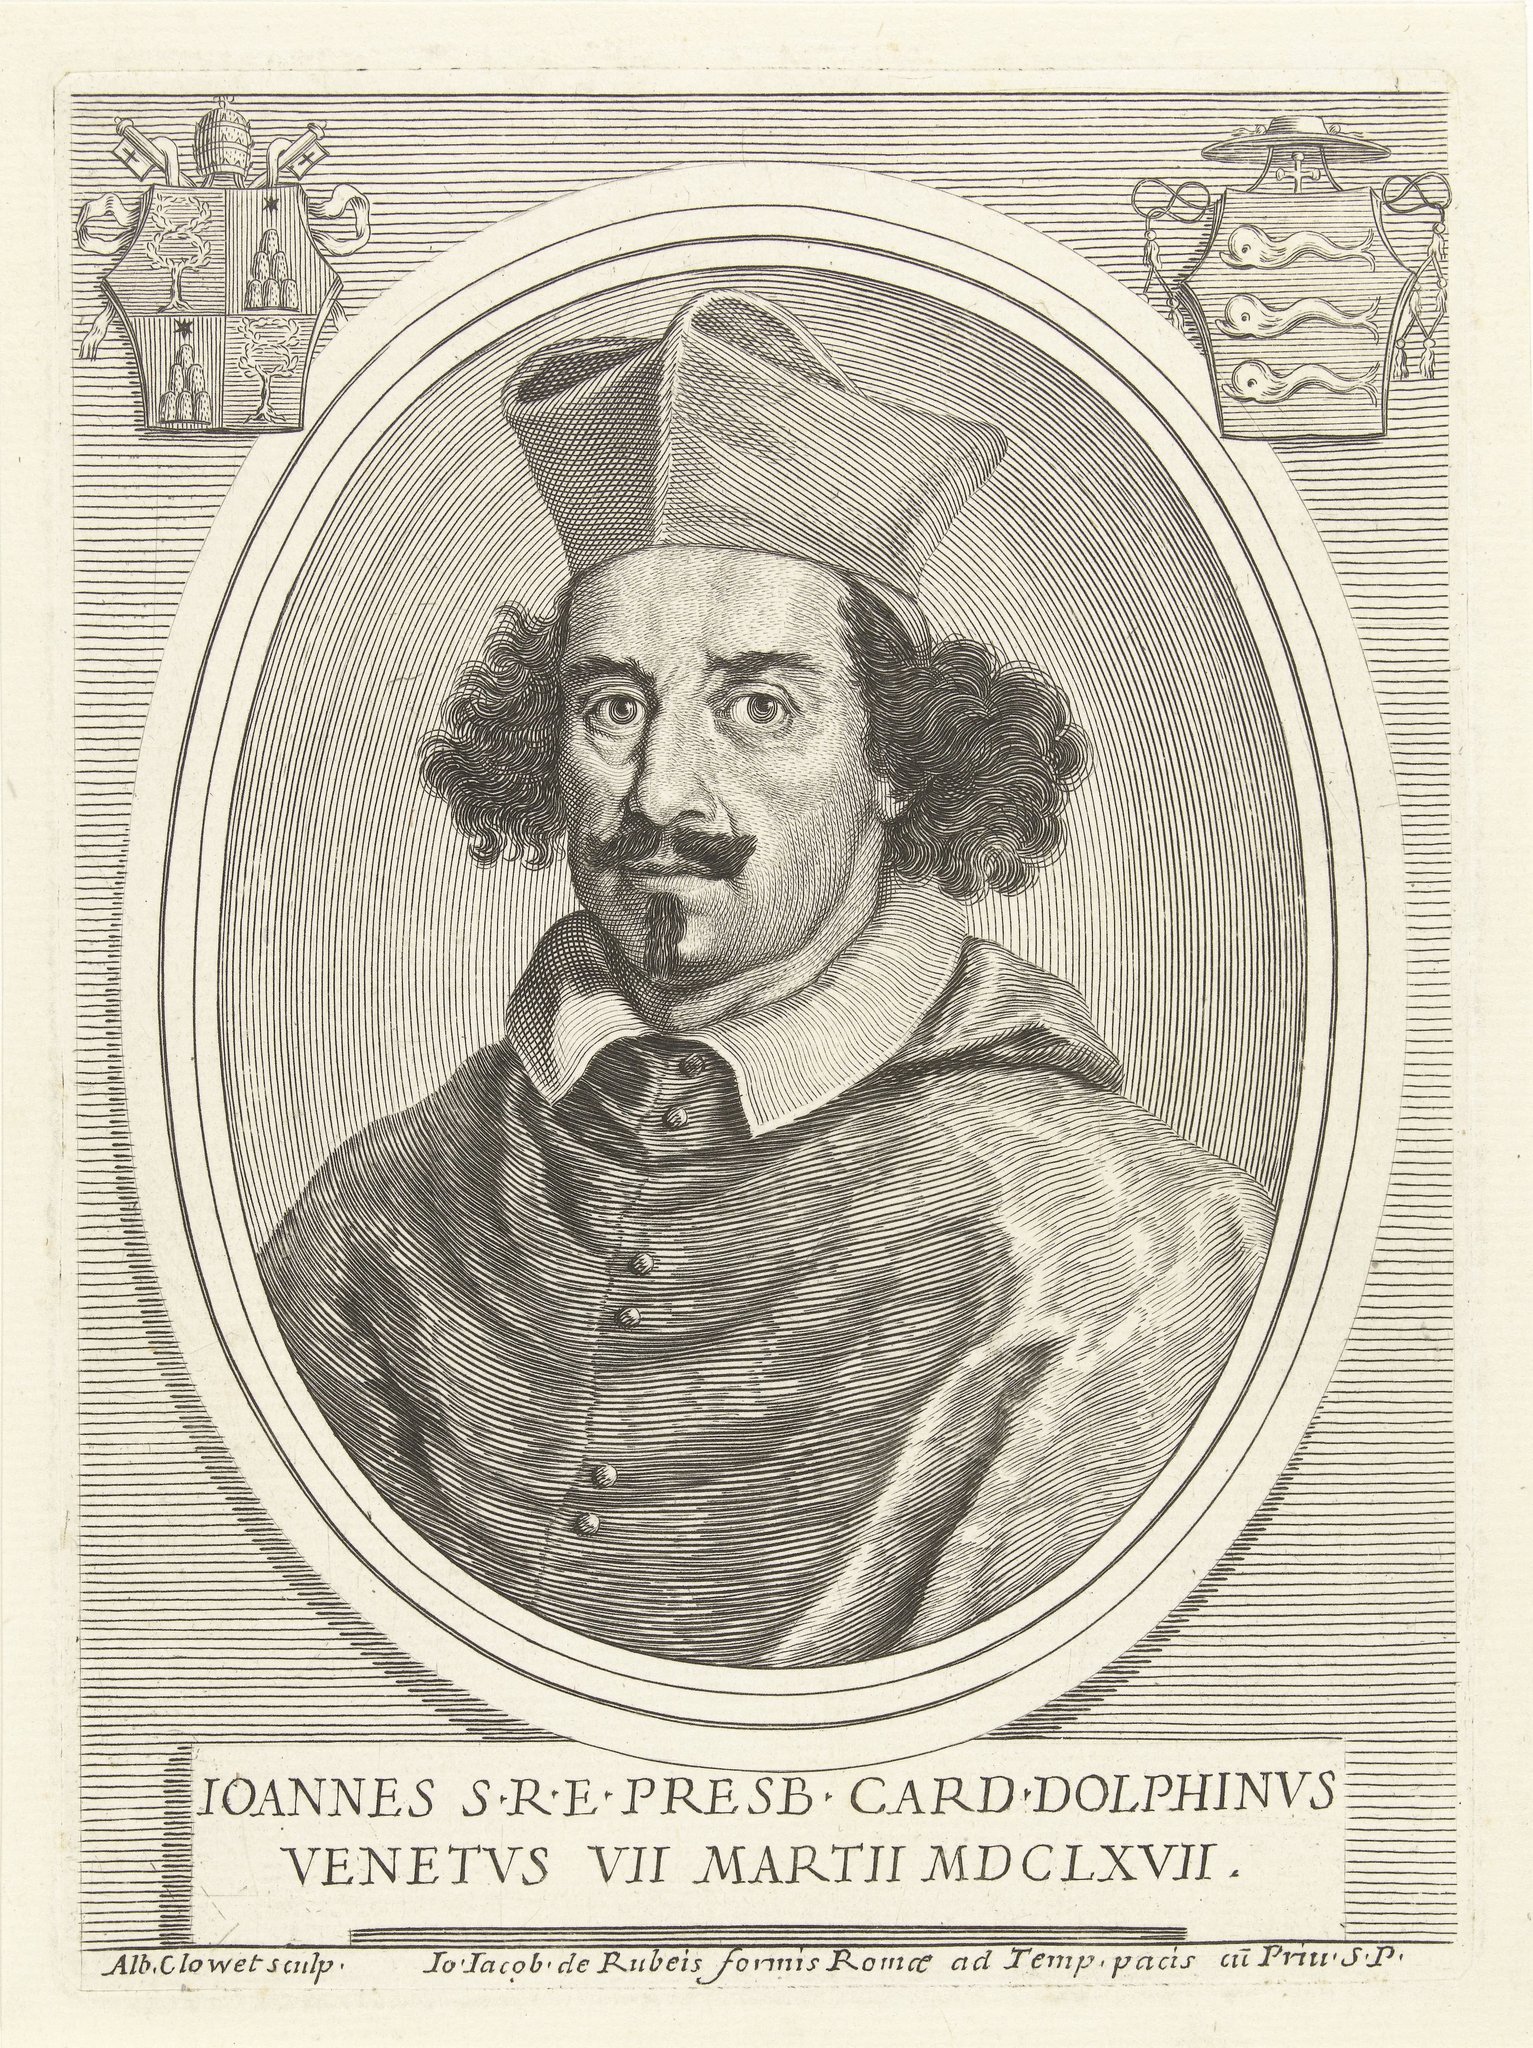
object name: print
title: Portret van kardinaal Giovanni Delfino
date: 1667-1679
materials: paper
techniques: engraving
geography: rome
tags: fidenza, kardinaal, innocenzo ciocchi del monte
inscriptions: collector's mark: Lugt 2228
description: Portret in ovale lijst van kardinaal Giovanni Delfino. Buste naar links. Bovenaan links het wapen van paus Alexander VII, bovenaan rechts het wapen van kardinaal Giovanni Delfino. De prent heeft een Latijns onderschrift met gegevens over de geportretteerde.